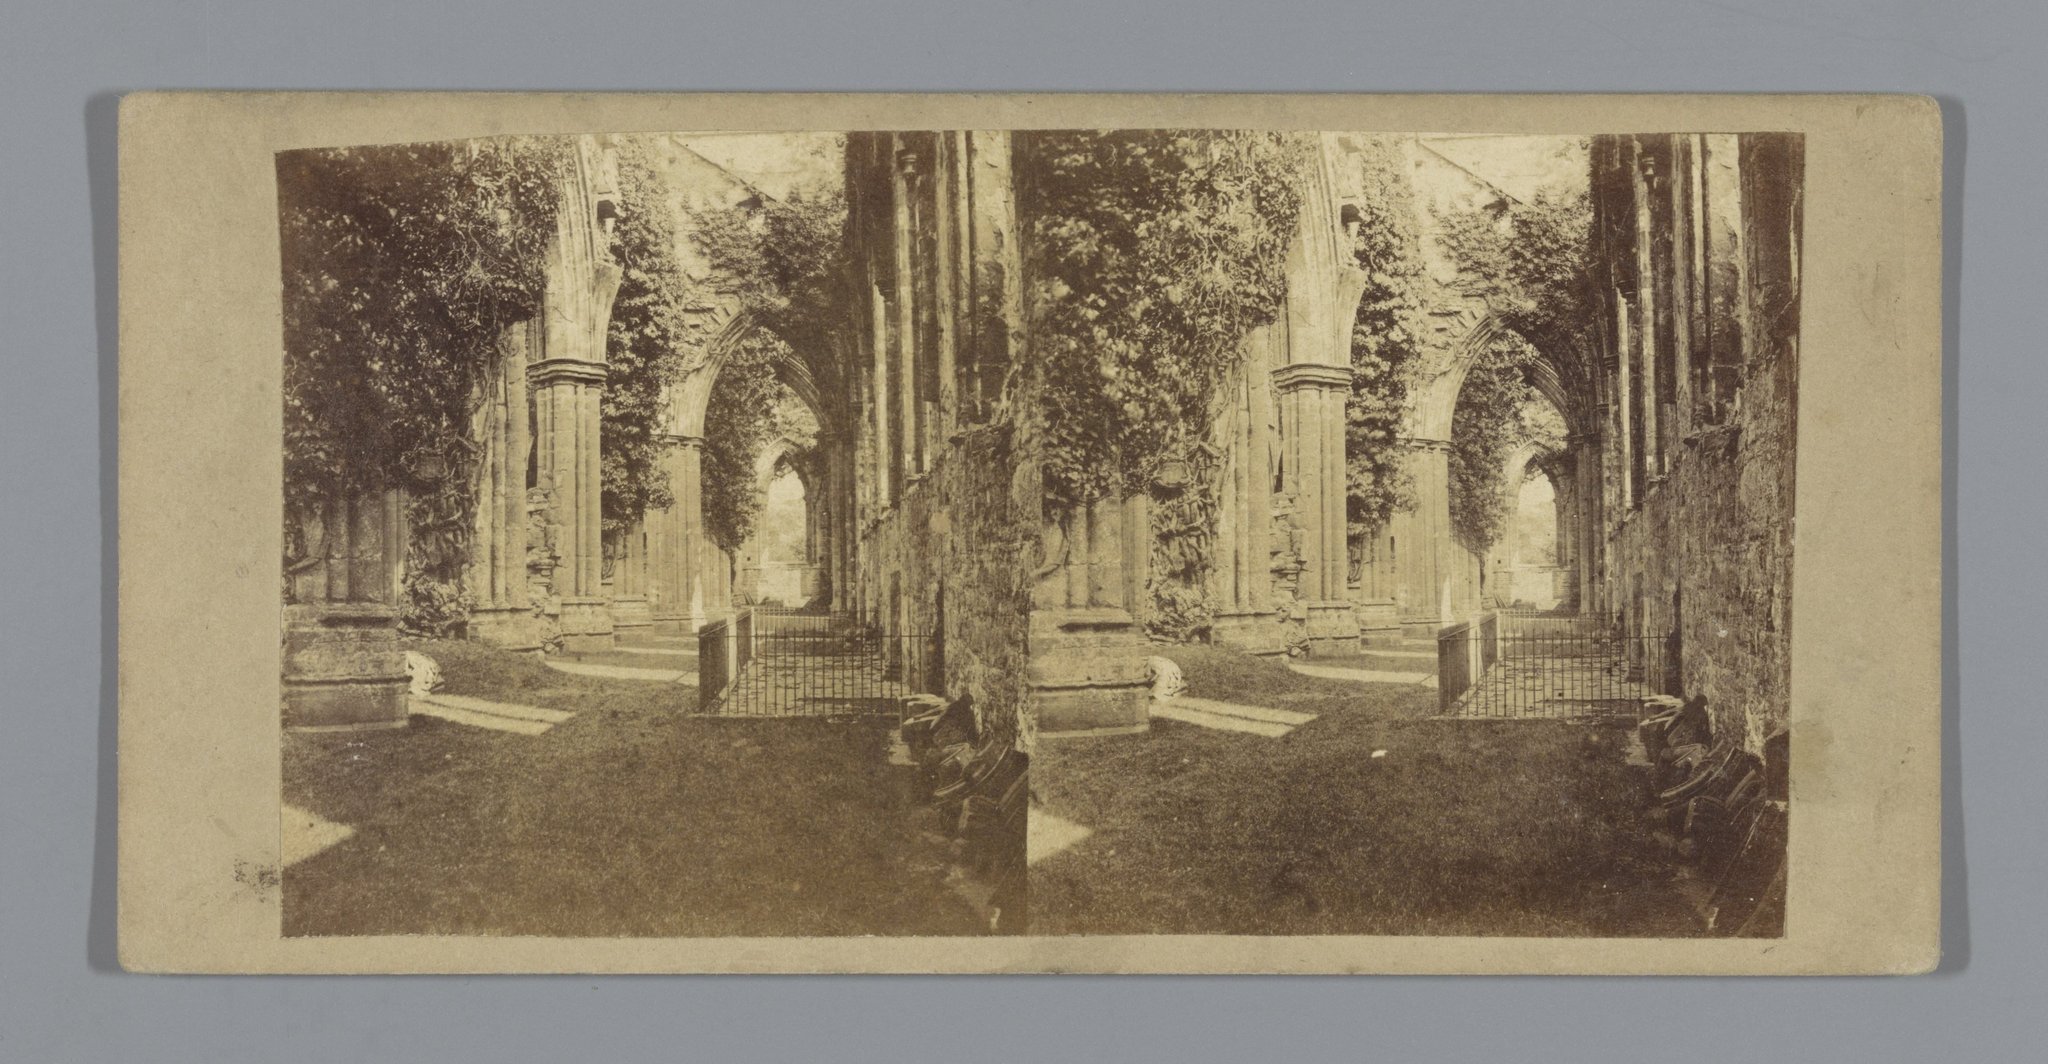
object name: stereograph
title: Gezicht op het interieur van de ruïne van Tintern Abbey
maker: Anonymous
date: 1860-1865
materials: cardboard, photographic support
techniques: albumen print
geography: tintern abbey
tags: ruin of church, monastery, etc.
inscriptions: inscription: ‘Tintern Abbey’